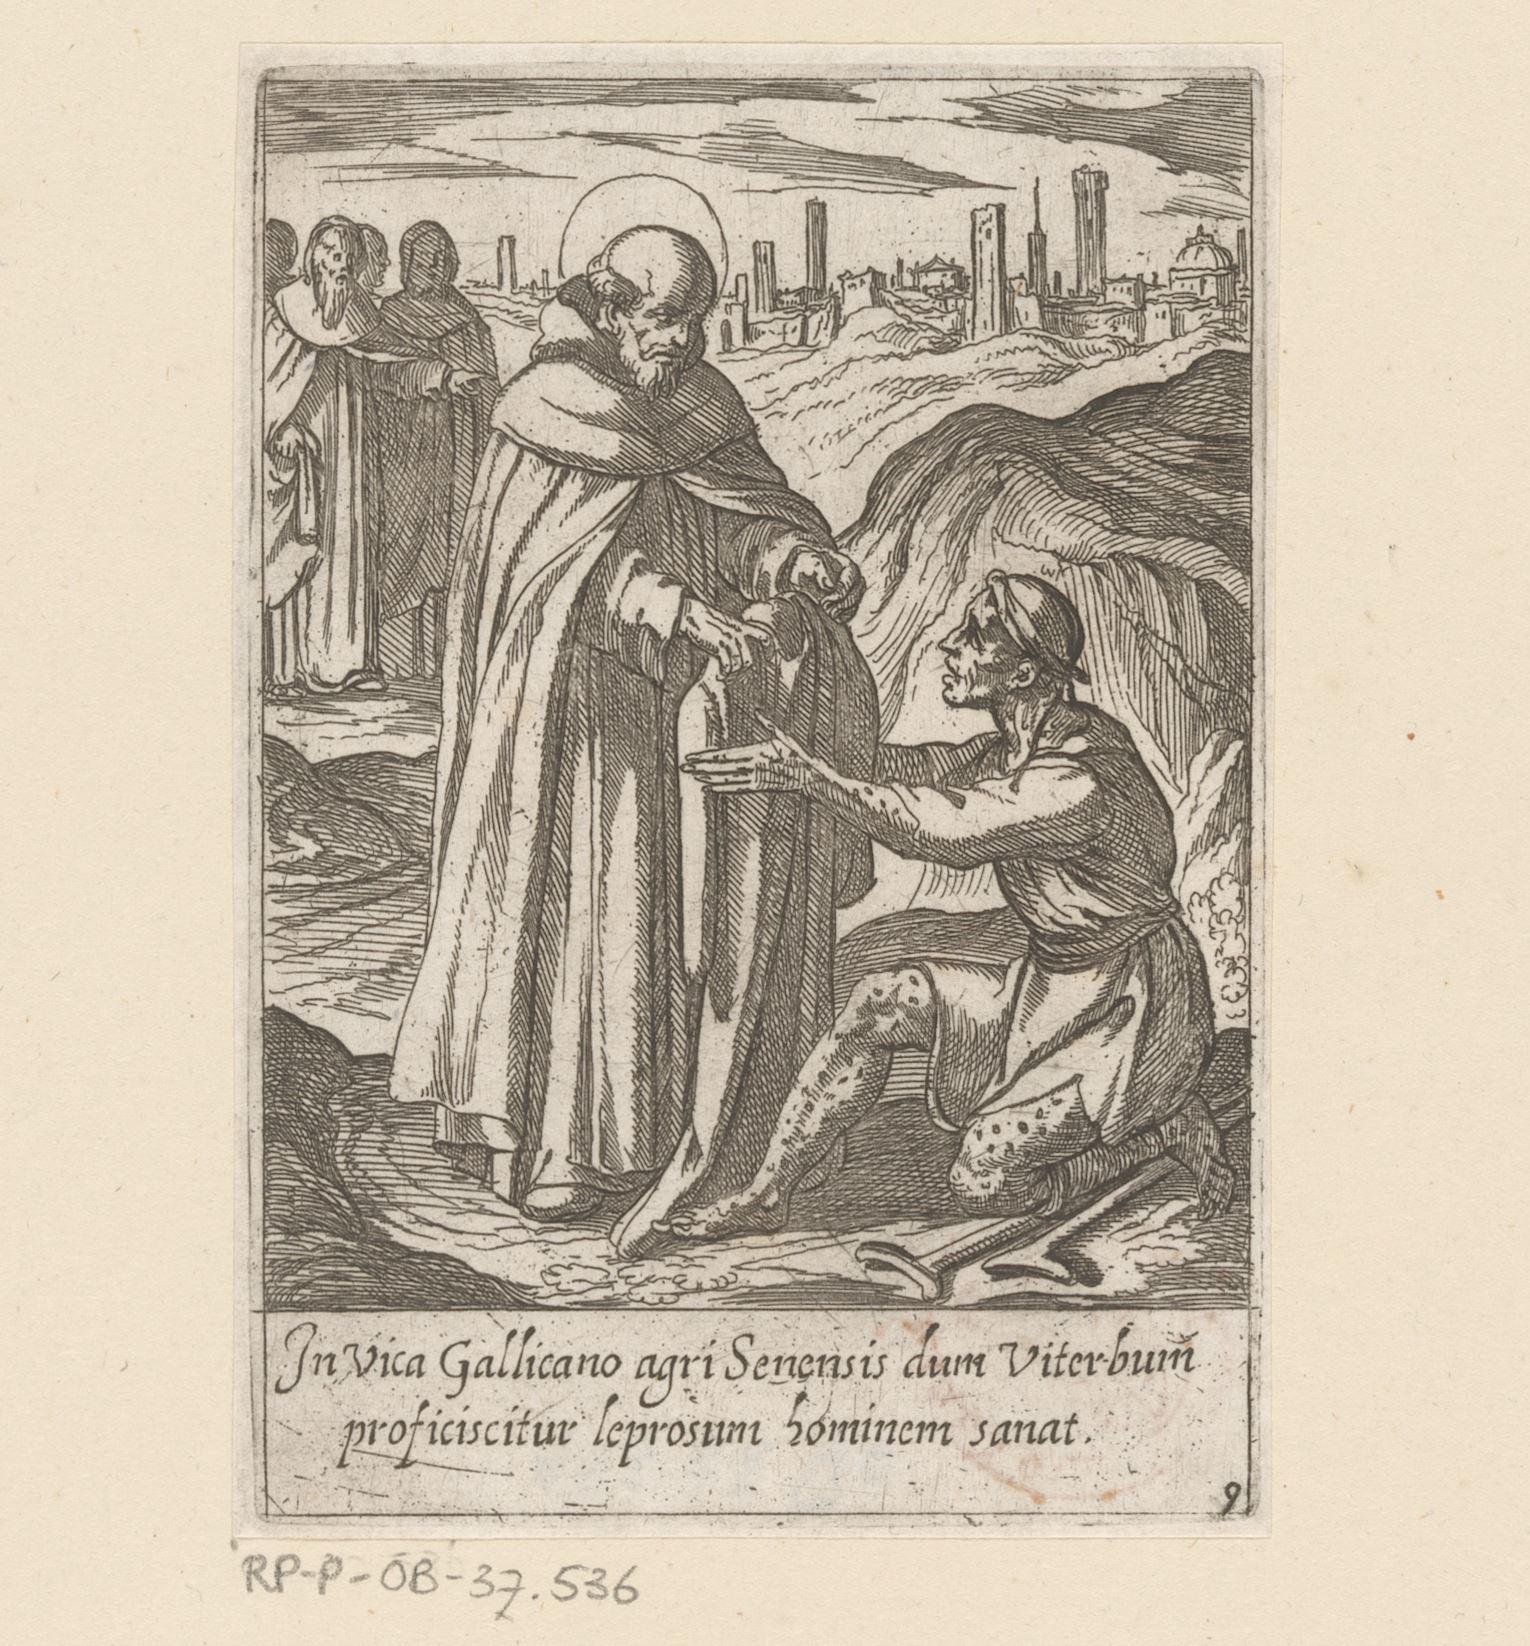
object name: print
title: Vita B. Philippi Benicii Florent. ord. servor B. Mariae virginis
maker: antonio tempesta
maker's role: draughtsman, painter, print maker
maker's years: 1555-1630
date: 1591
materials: paper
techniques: etching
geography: rome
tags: clergyman, miraculous activities and events ~ st. philip benizzi, prior general of the order of the servites, philip benizzi of florence; possible attributes: book, cross, lily, tiara at his feet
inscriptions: collector's mark: Lugt 240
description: De heilige Philippus geneest een leproos en geeft hem een mantel. Op de achtergrond een stadsgezicht. Tekst in het Latijn in ondermarge. Genummerd rechtsonder: 9.